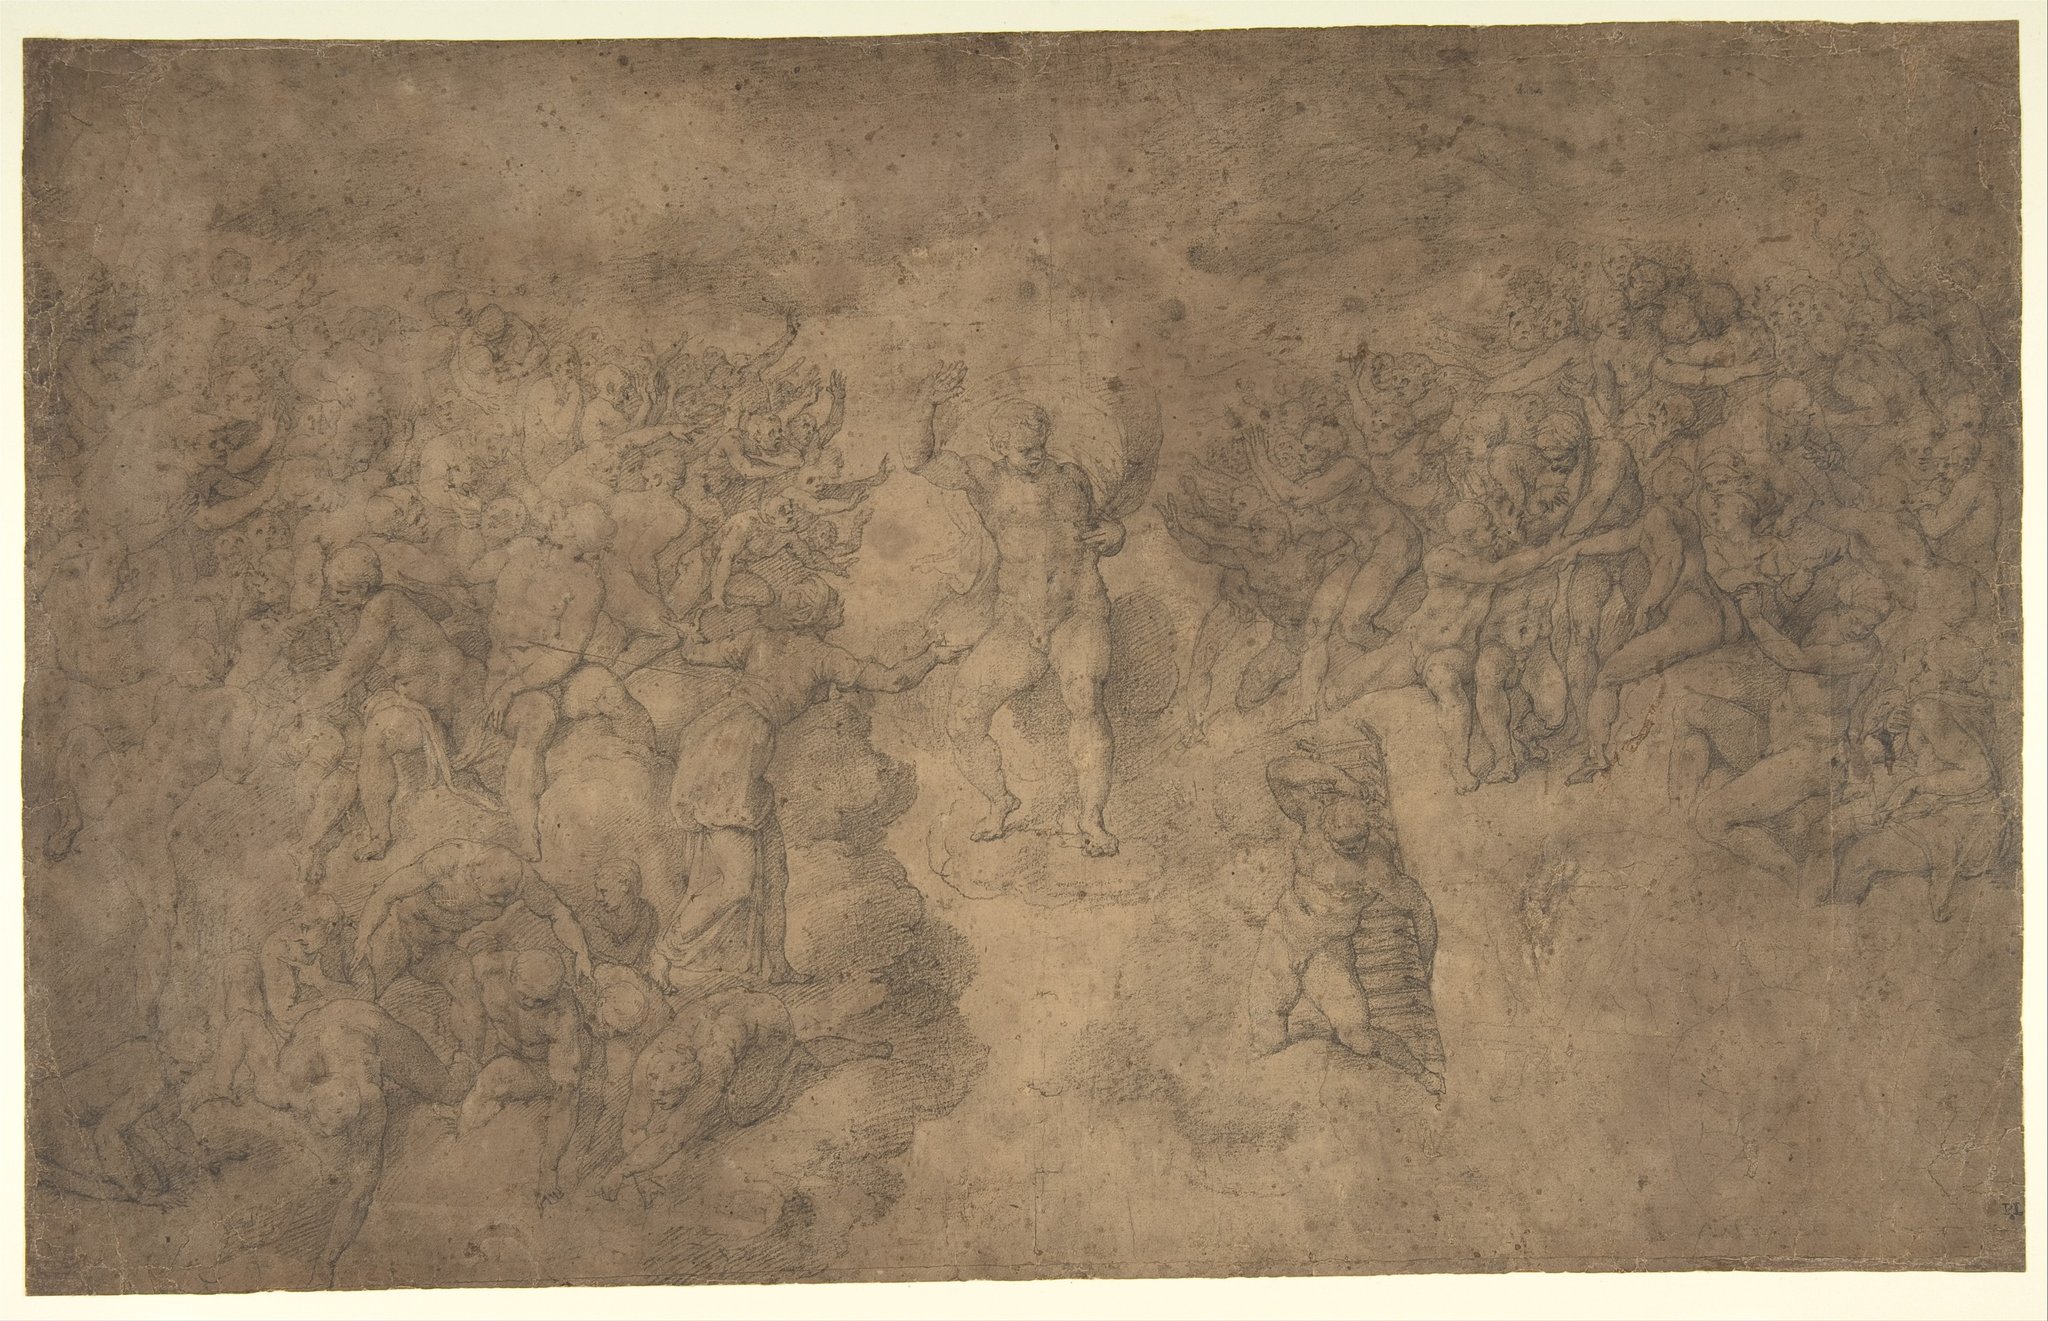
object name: drawing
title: The Last Judgment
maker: michelangelo buonarroti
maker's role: artist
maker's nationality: italian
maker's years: 1475-1564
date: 1570-1590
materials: chalk, paper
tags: male nudes,last judgement